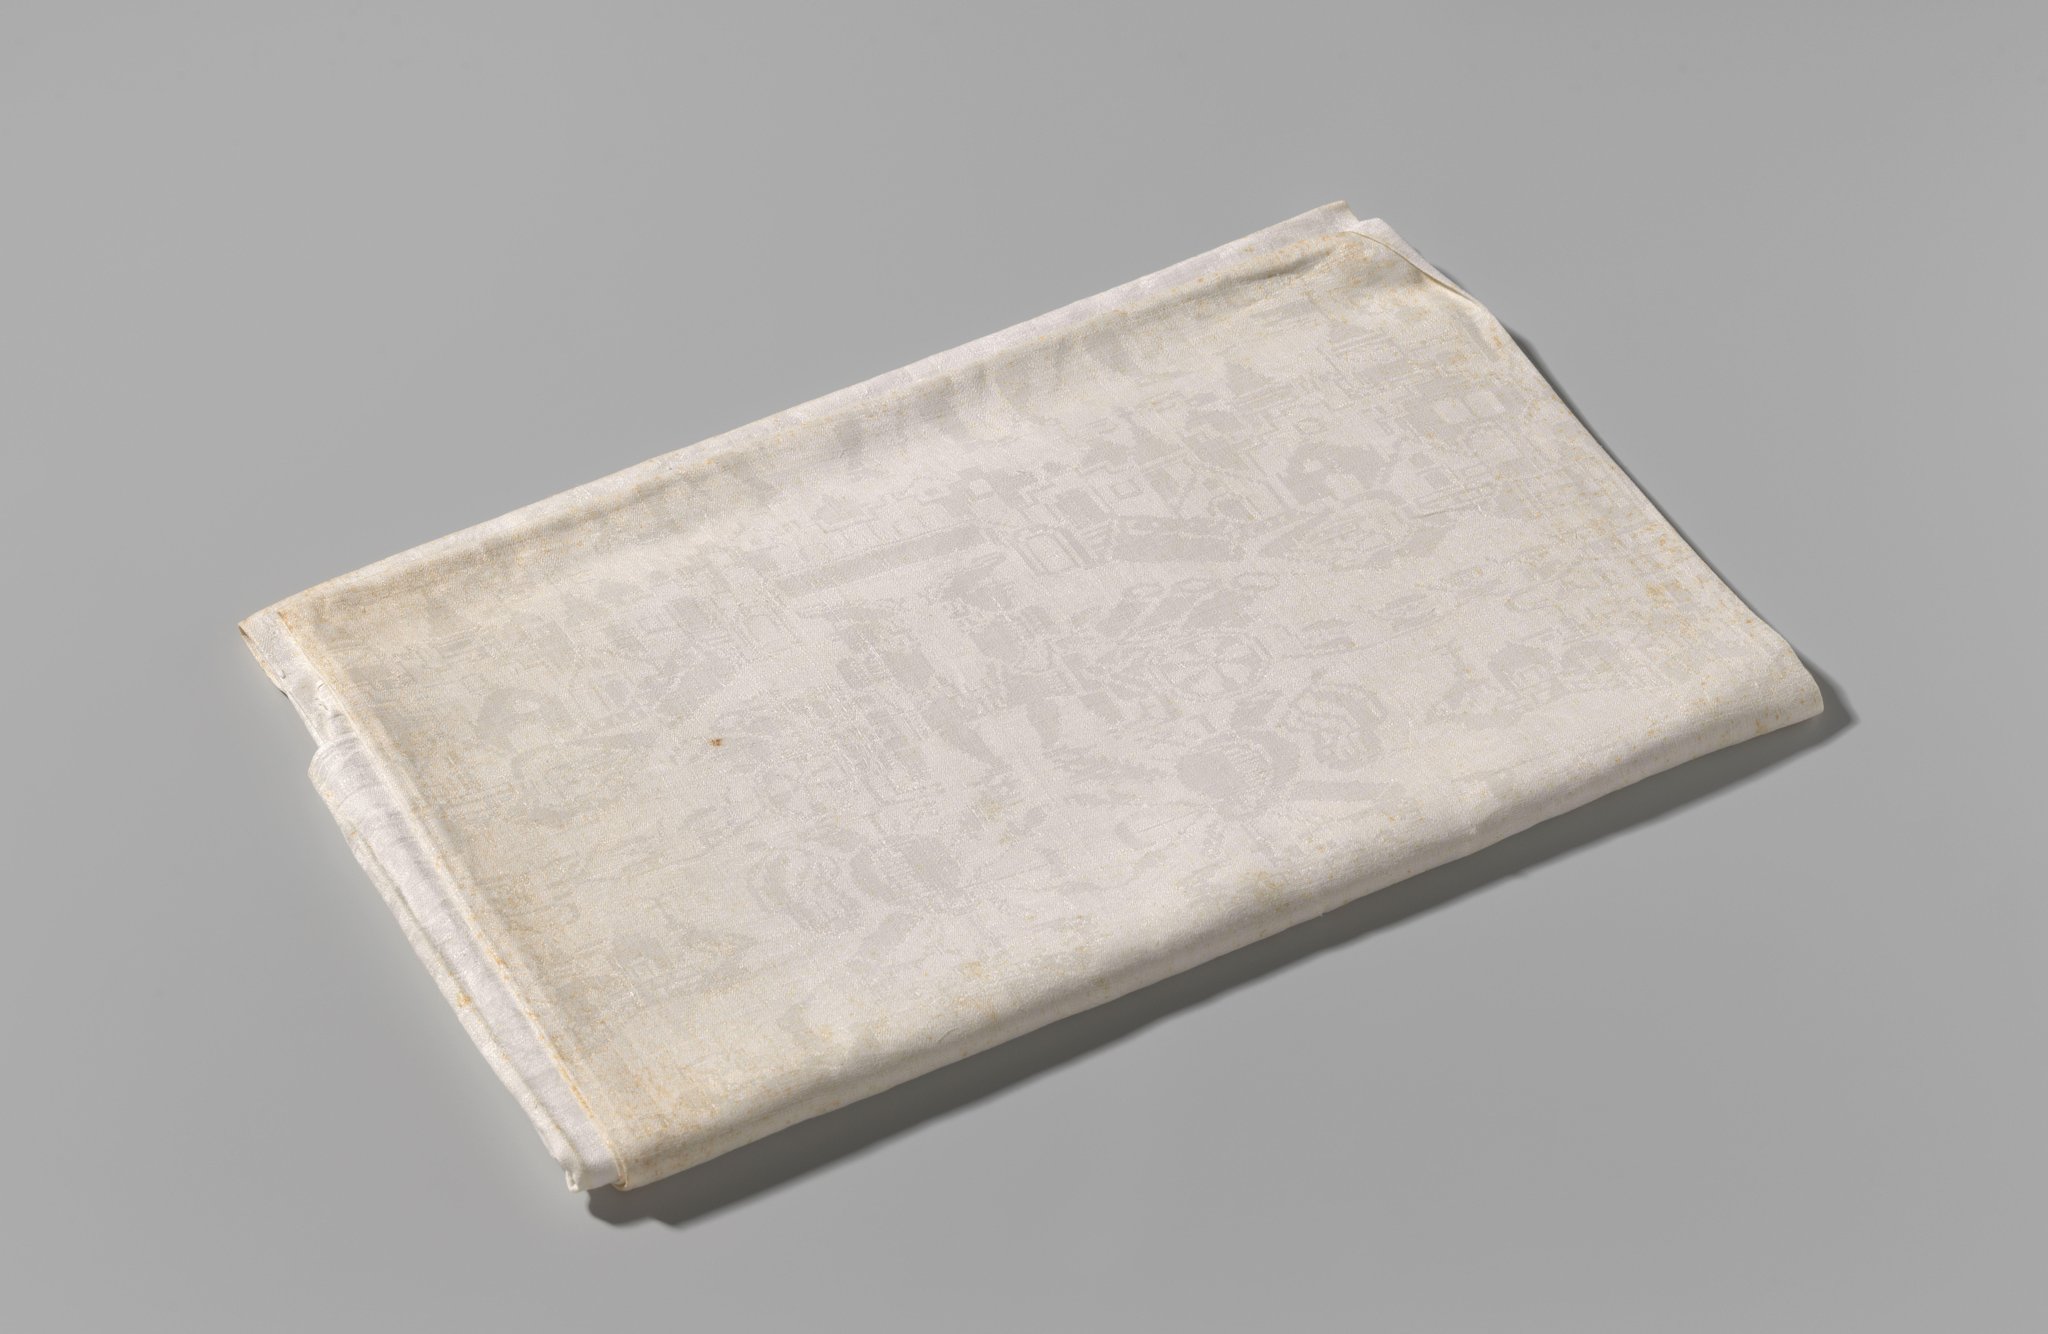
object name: tablecloth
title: Tafellaken van linnendamast met een historisch tafereel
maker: Anonymous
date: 1745-1750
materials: linen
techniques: damask, weave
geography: flanders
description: Tafellaken van linnendamast met de verovering van Gent en de slag bij Fontenoy door Lodewijk XV en de Dauphin (1745).